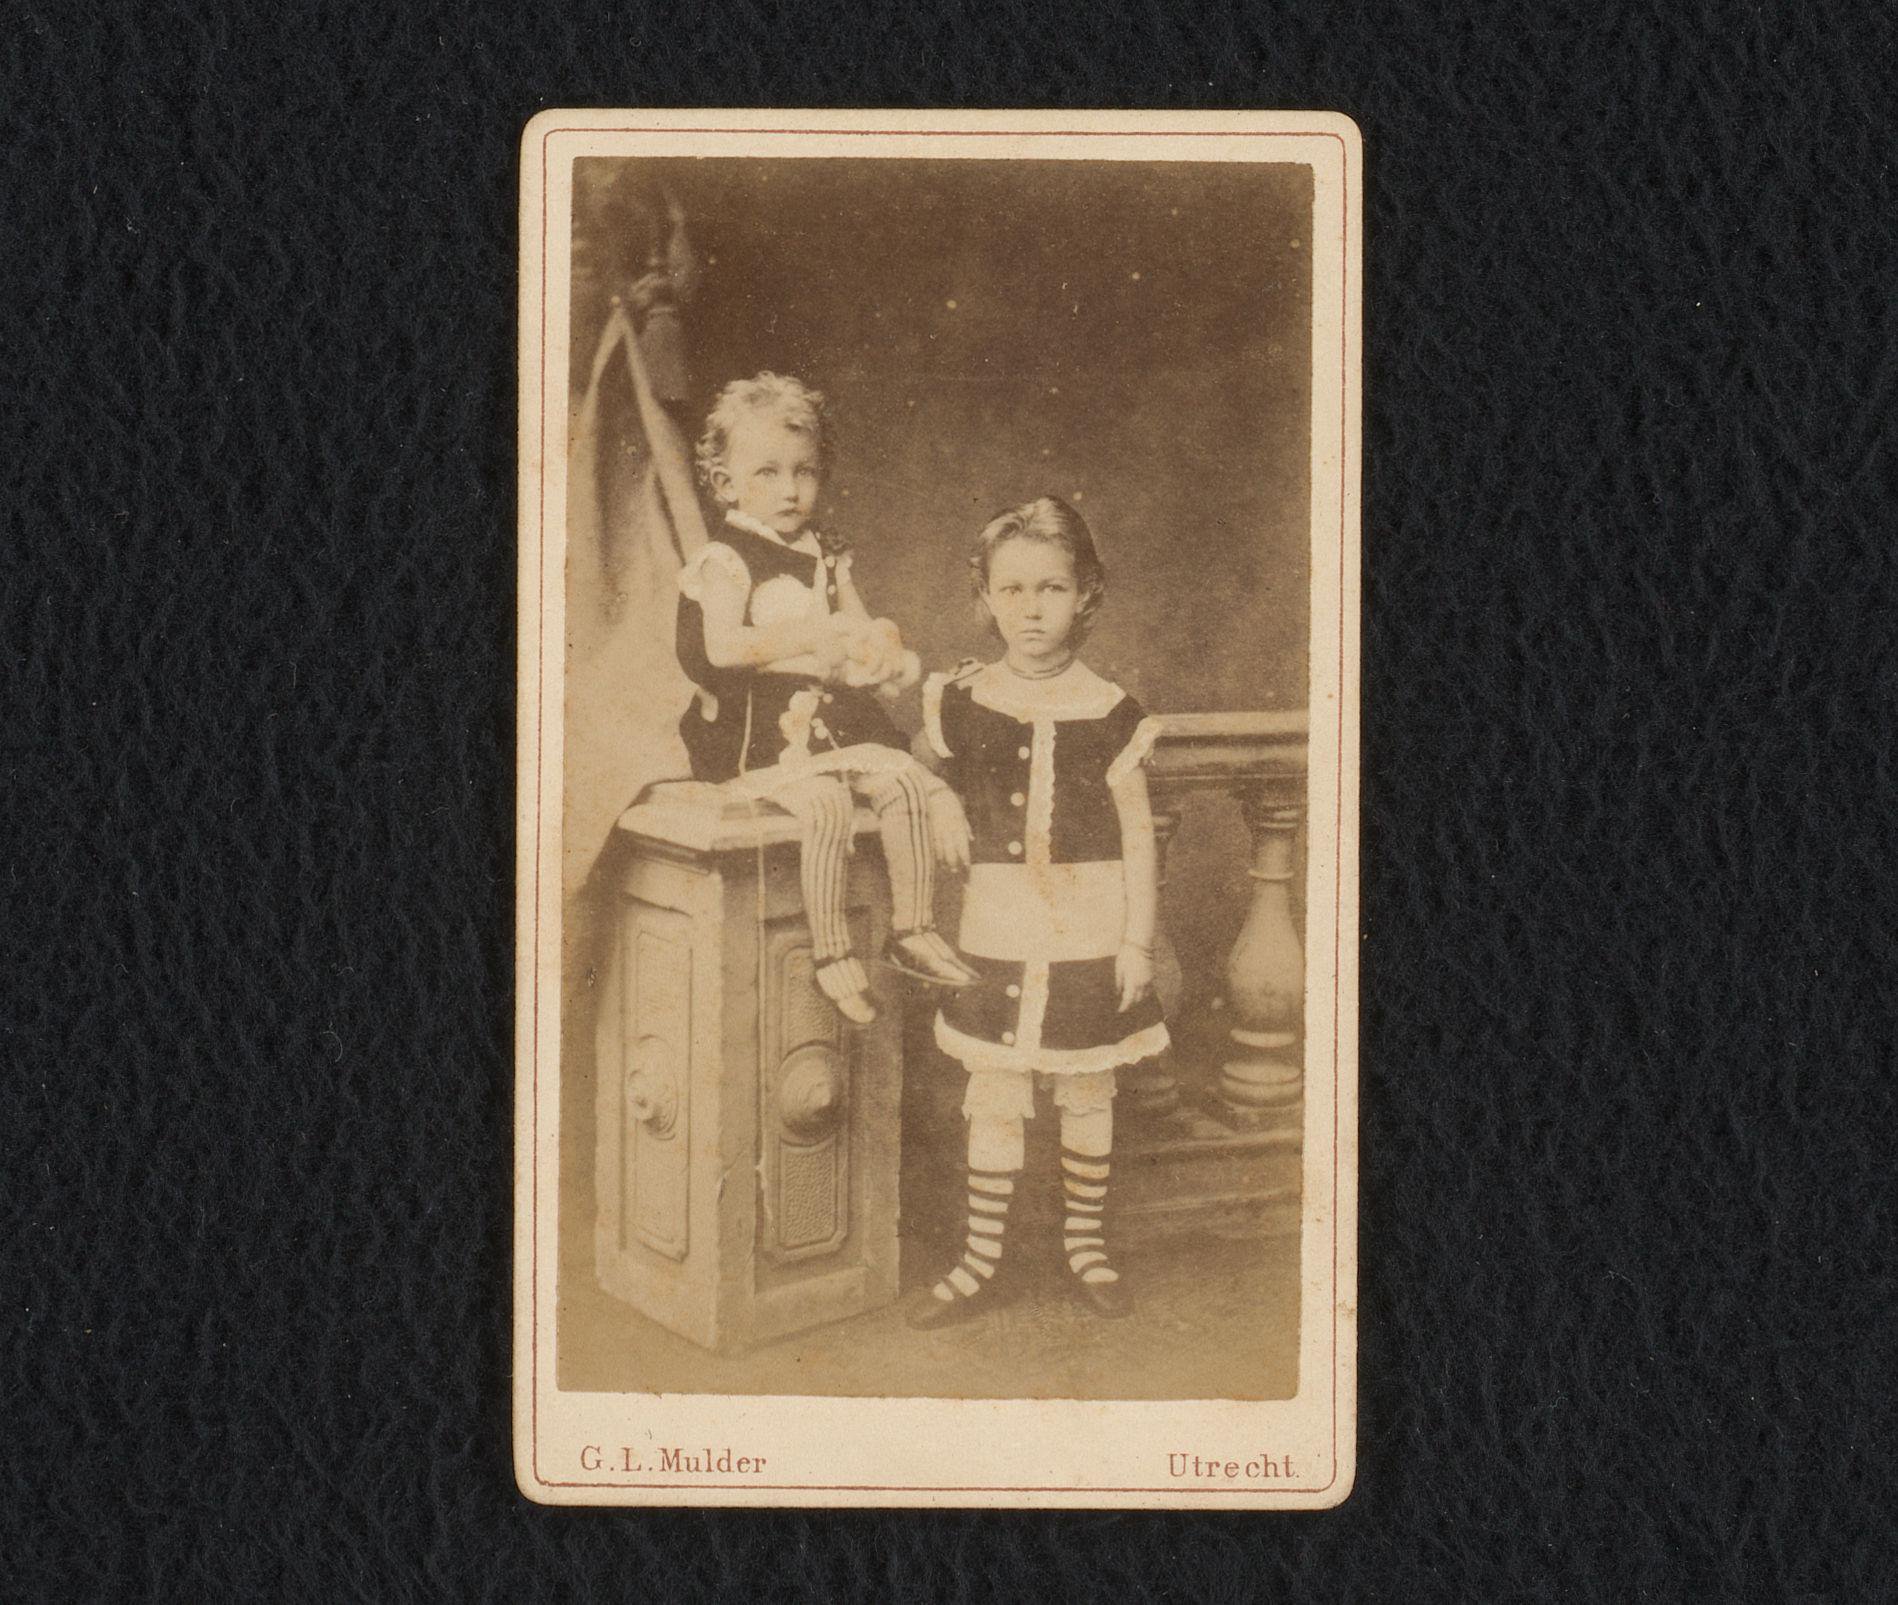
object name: carte de visite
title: Portret van Gerda en Sjoerd Spruijt Landskroon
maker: george lodewijk mulder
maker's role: fotograaf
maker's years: 1841-1920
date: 1882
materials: cardboard, paper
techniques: albumen print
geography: utrecht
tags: historical persons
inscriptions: inscription: ‘Gerda Bertha/ Spruyt Landskroon/ 4 jaar oud./ Sjoerd Hendrik/ Spruyt Landskroon/ 2 jaar oud’, address: ‘van Wijckskade H.326./ UTRECHT.’